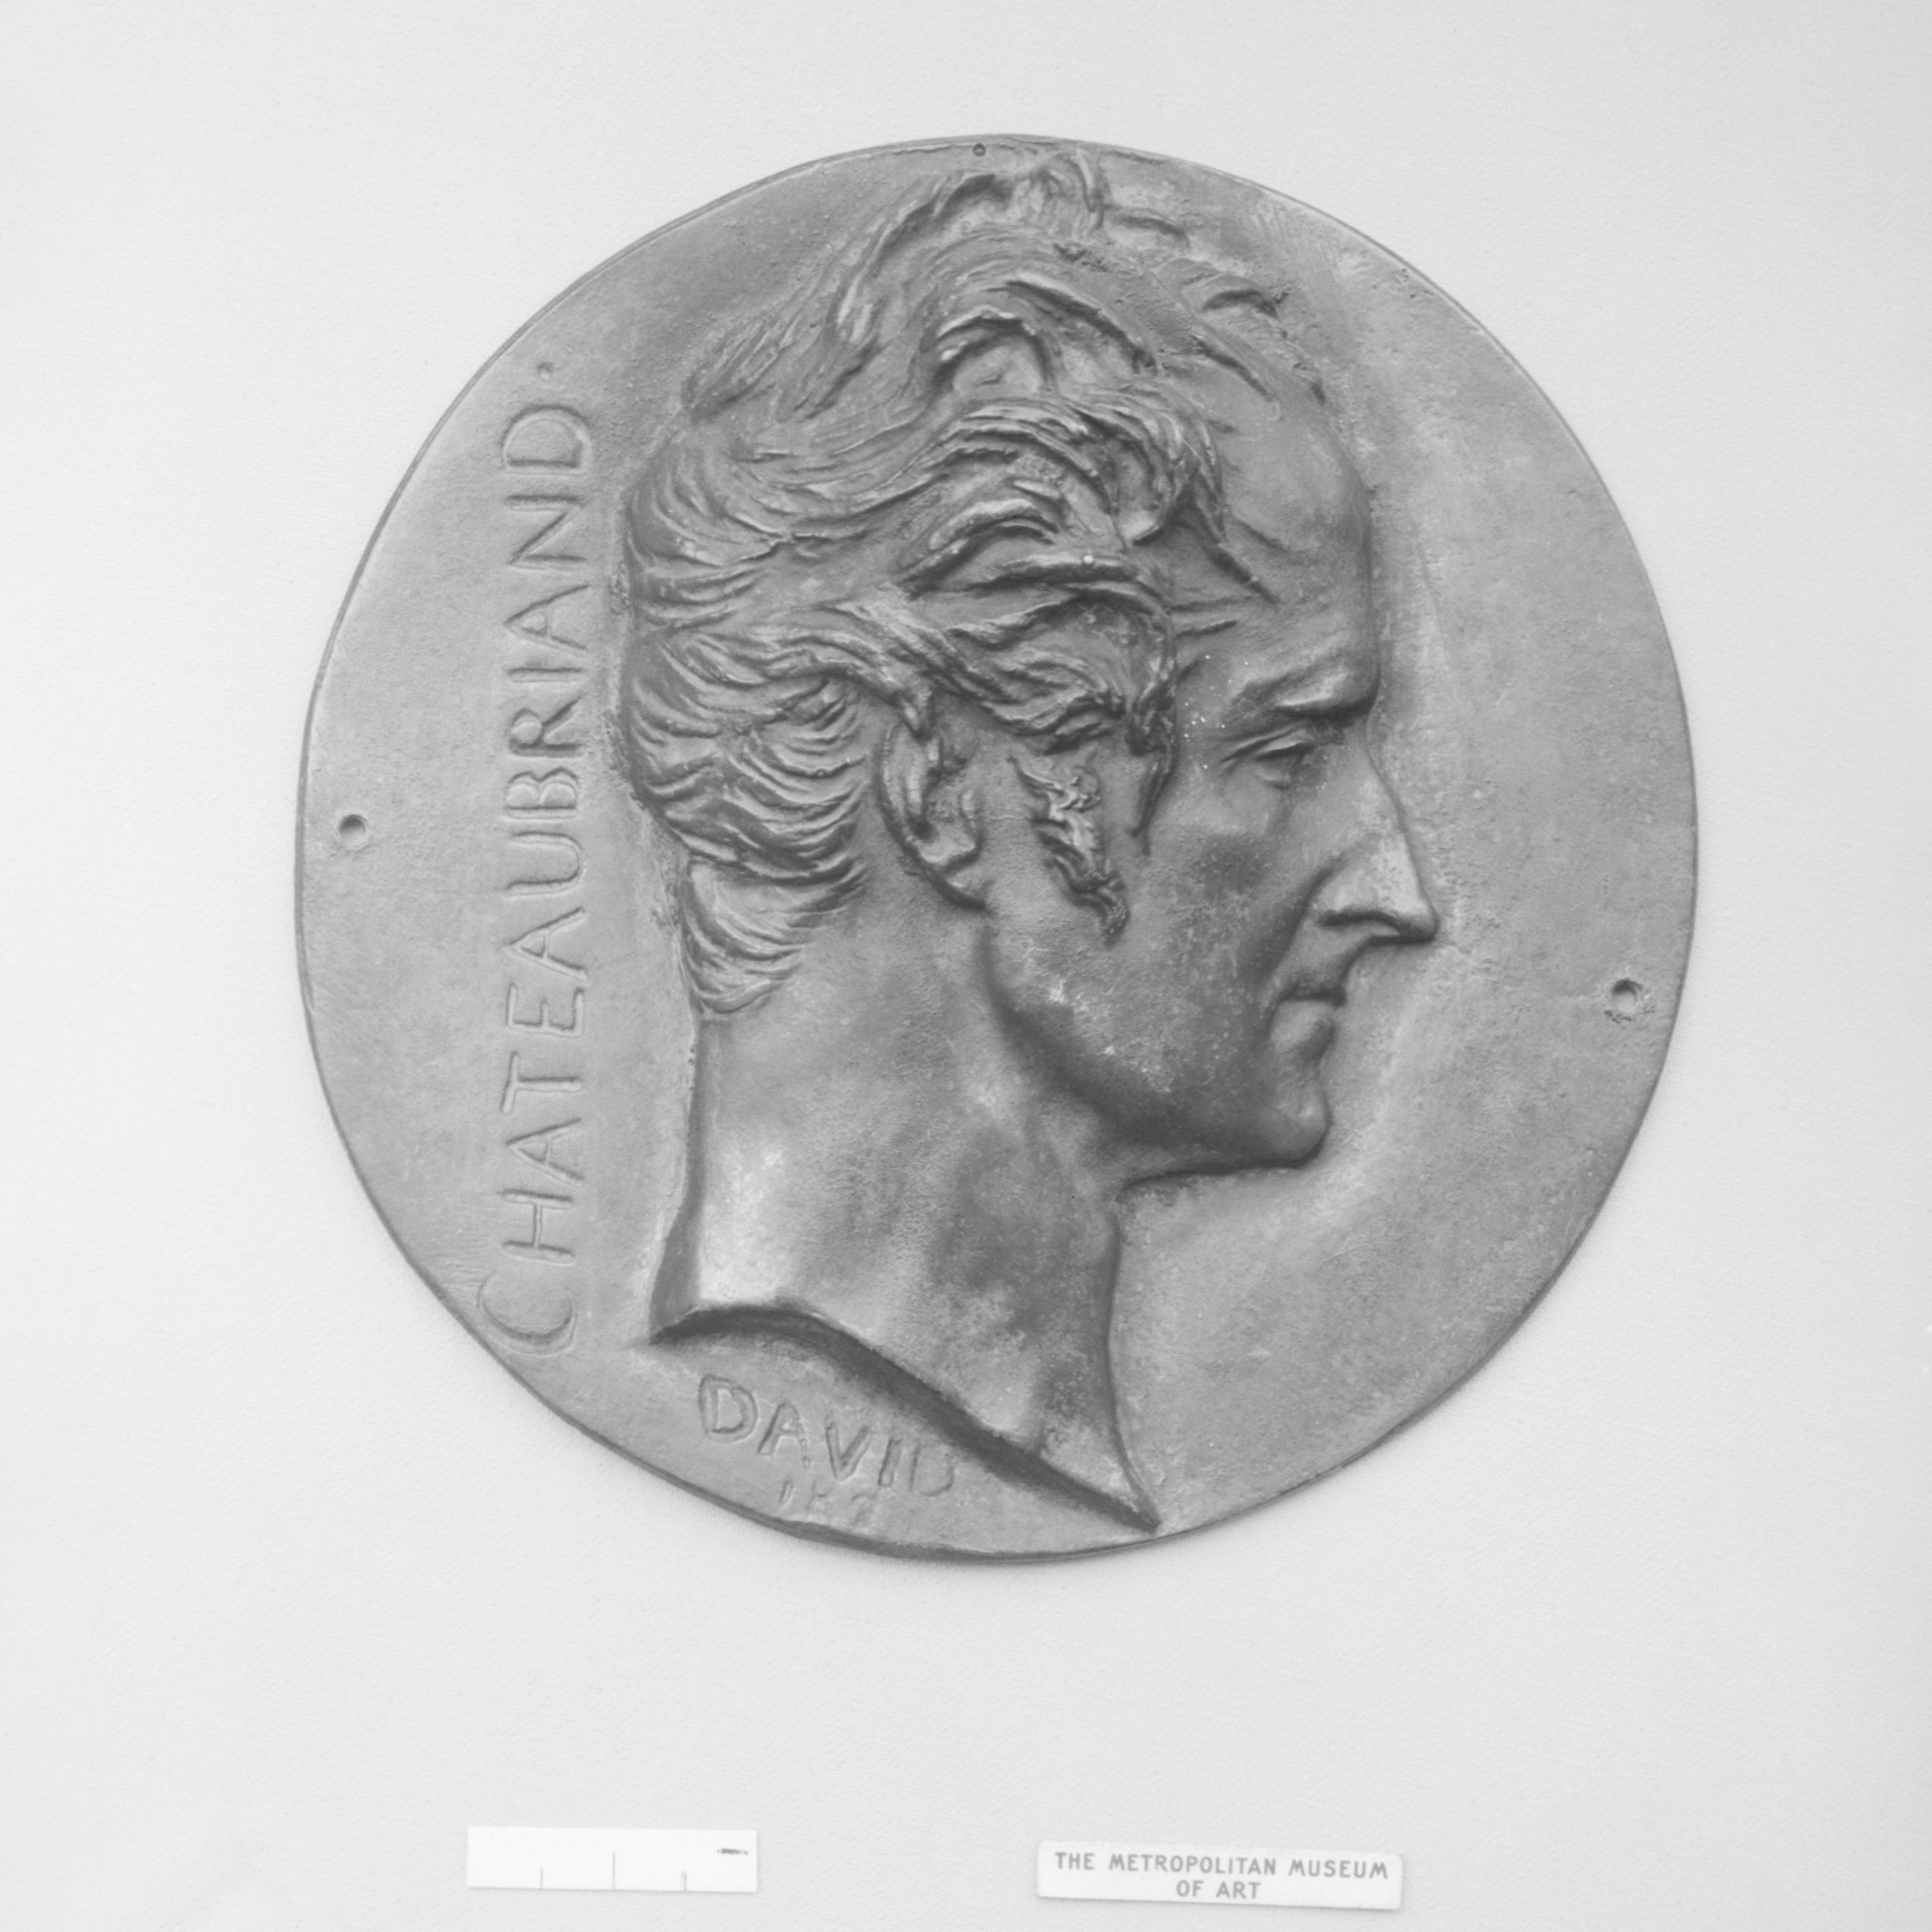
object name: medallion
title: François René Auguste Vicomte de Chateaubriand (1768–1848), French statesman and man-of-letters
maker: pierre jean david d'angers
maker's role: artist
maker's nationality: french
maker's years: 1788-1856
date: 1801-1900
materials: bronze, patina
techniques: casting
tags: men,profiles